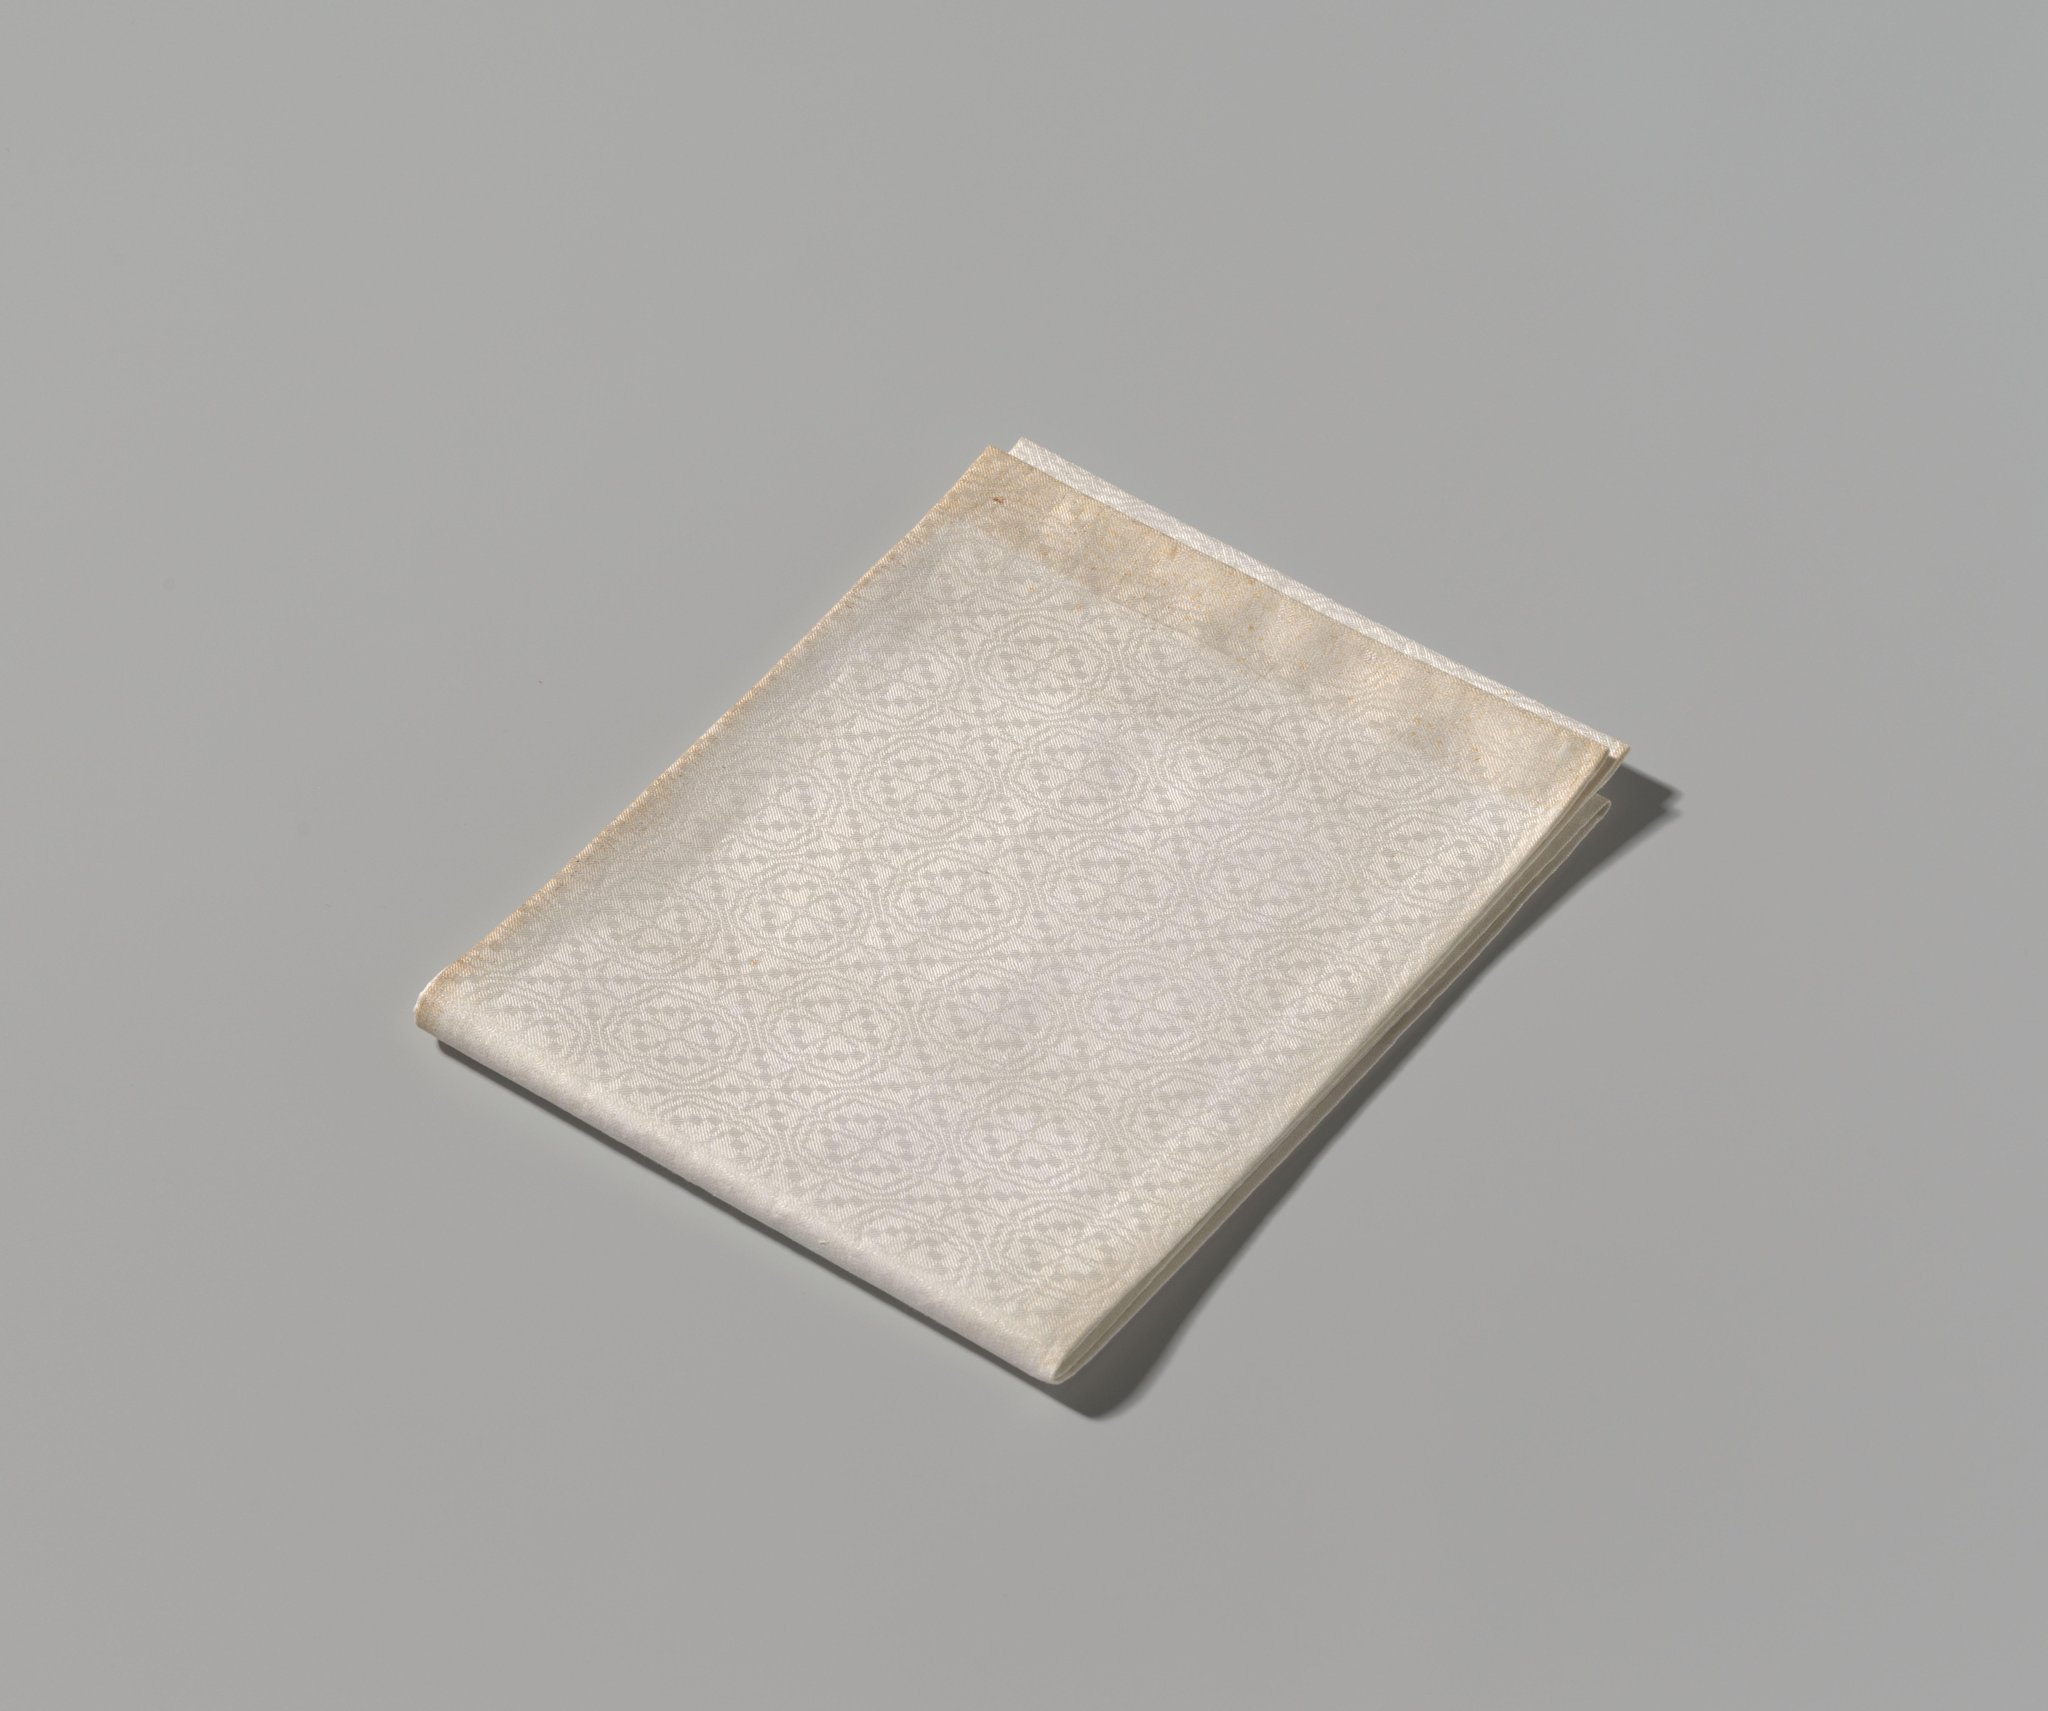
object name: towel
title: Handdwaal van wit linnen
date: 1640-1670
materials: linen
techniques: peeled fabric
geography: northern netherlands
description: Handdwaal van wit linnen. Pellen keper. Merk TC en ?